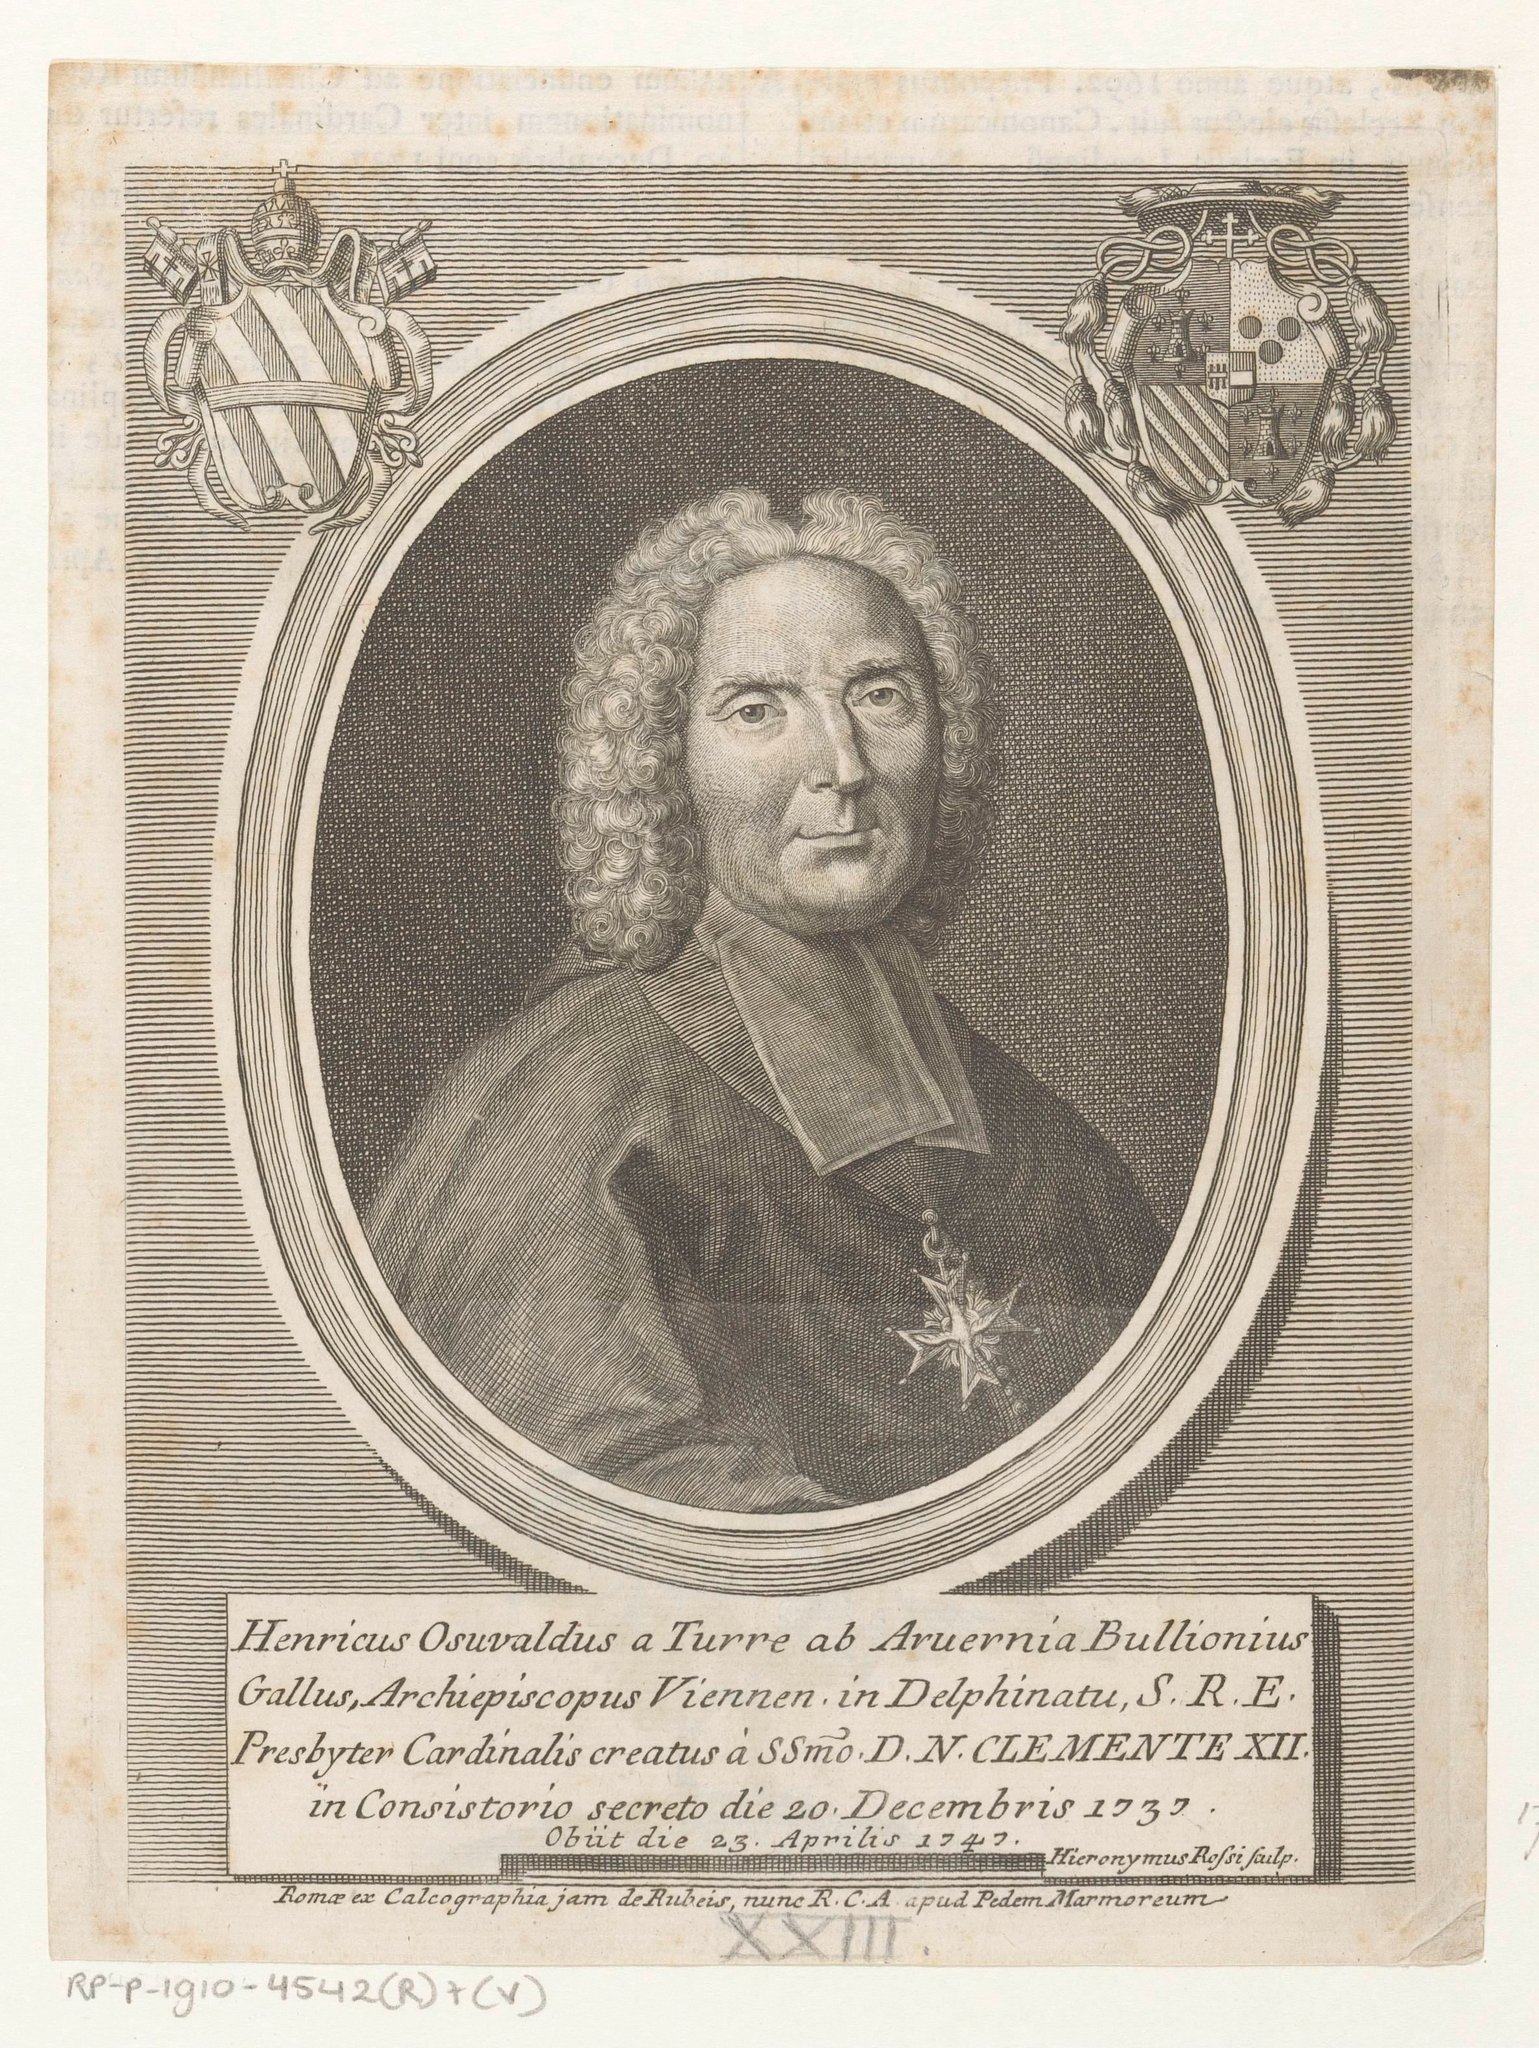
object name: book illustration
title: Portret van kardinaal Henri-Osvald de La Tour d'Auvergne de Bouillon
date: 1747-1762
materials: paper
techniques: engraving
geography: rome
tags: paris, cardinal, historical persons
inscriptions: inscription: ‘XXIII’